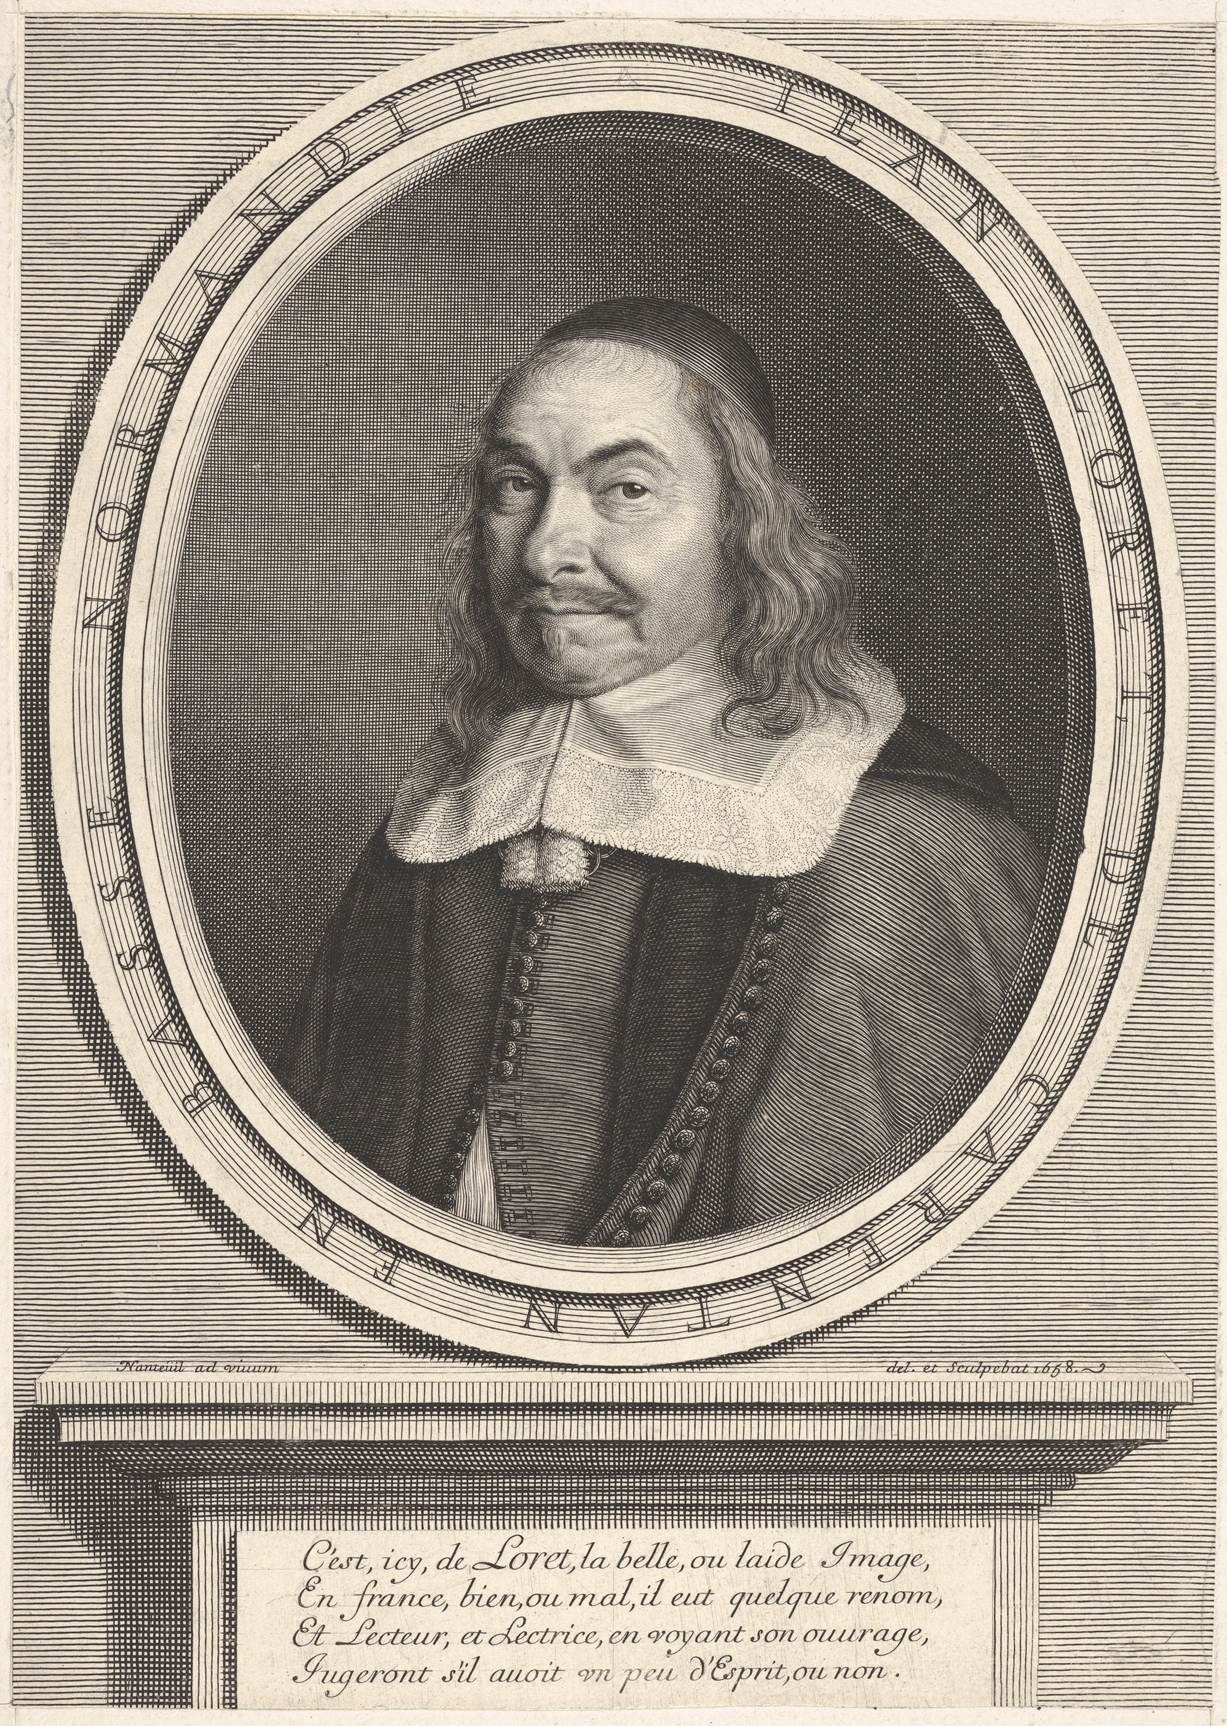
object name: print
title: Jean Loret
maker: robert nanteuil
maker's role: artist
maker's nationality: french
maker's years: 1623-1678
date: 1658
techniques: engraving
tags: men,portraits